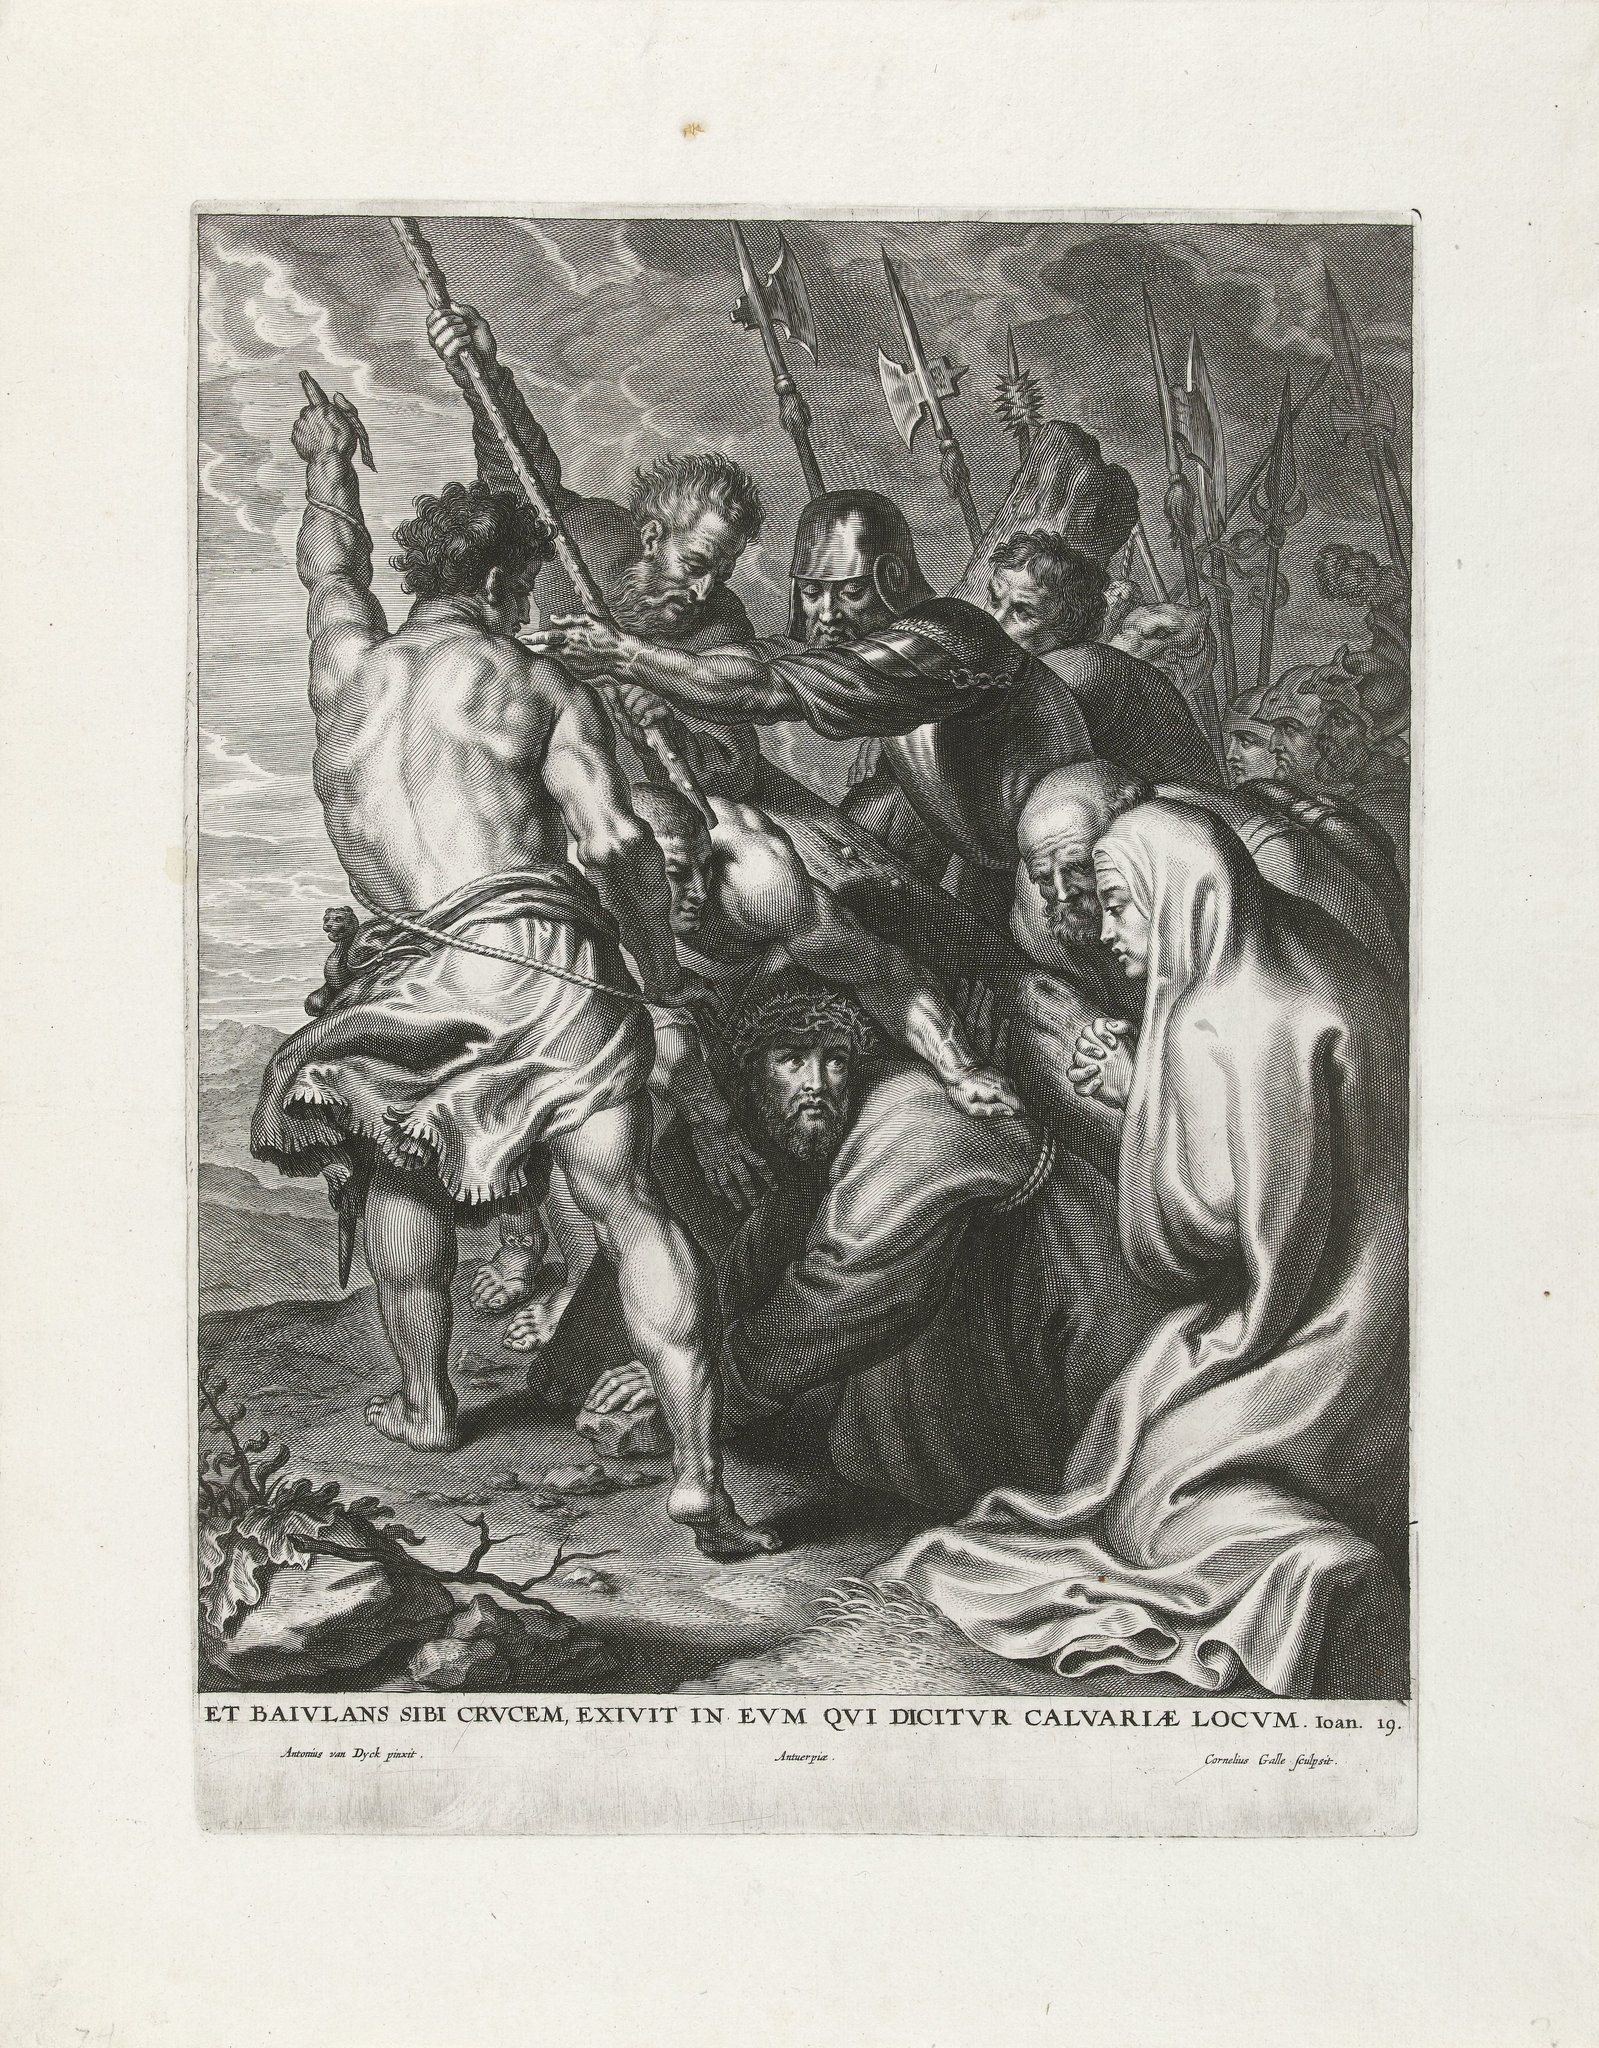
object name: print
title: Kruisdraging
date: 1586-1650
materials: paper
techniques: engraving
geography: antwerp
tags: christ collapsing ~ carrying of the cross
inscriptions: collector's mark: Lugt 240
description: Omringd door een menigte draagt Christus het kruis naar Golgotha. Hij steunt op handen en knieën en dreigt te bezwijken onder zijn last. Soldaten drijven hem aan en trekken hem verder. Naast het kruis knielt Maria met gevouwen handen, Simon van Cyrene helpt Christus zijn last te dragen.